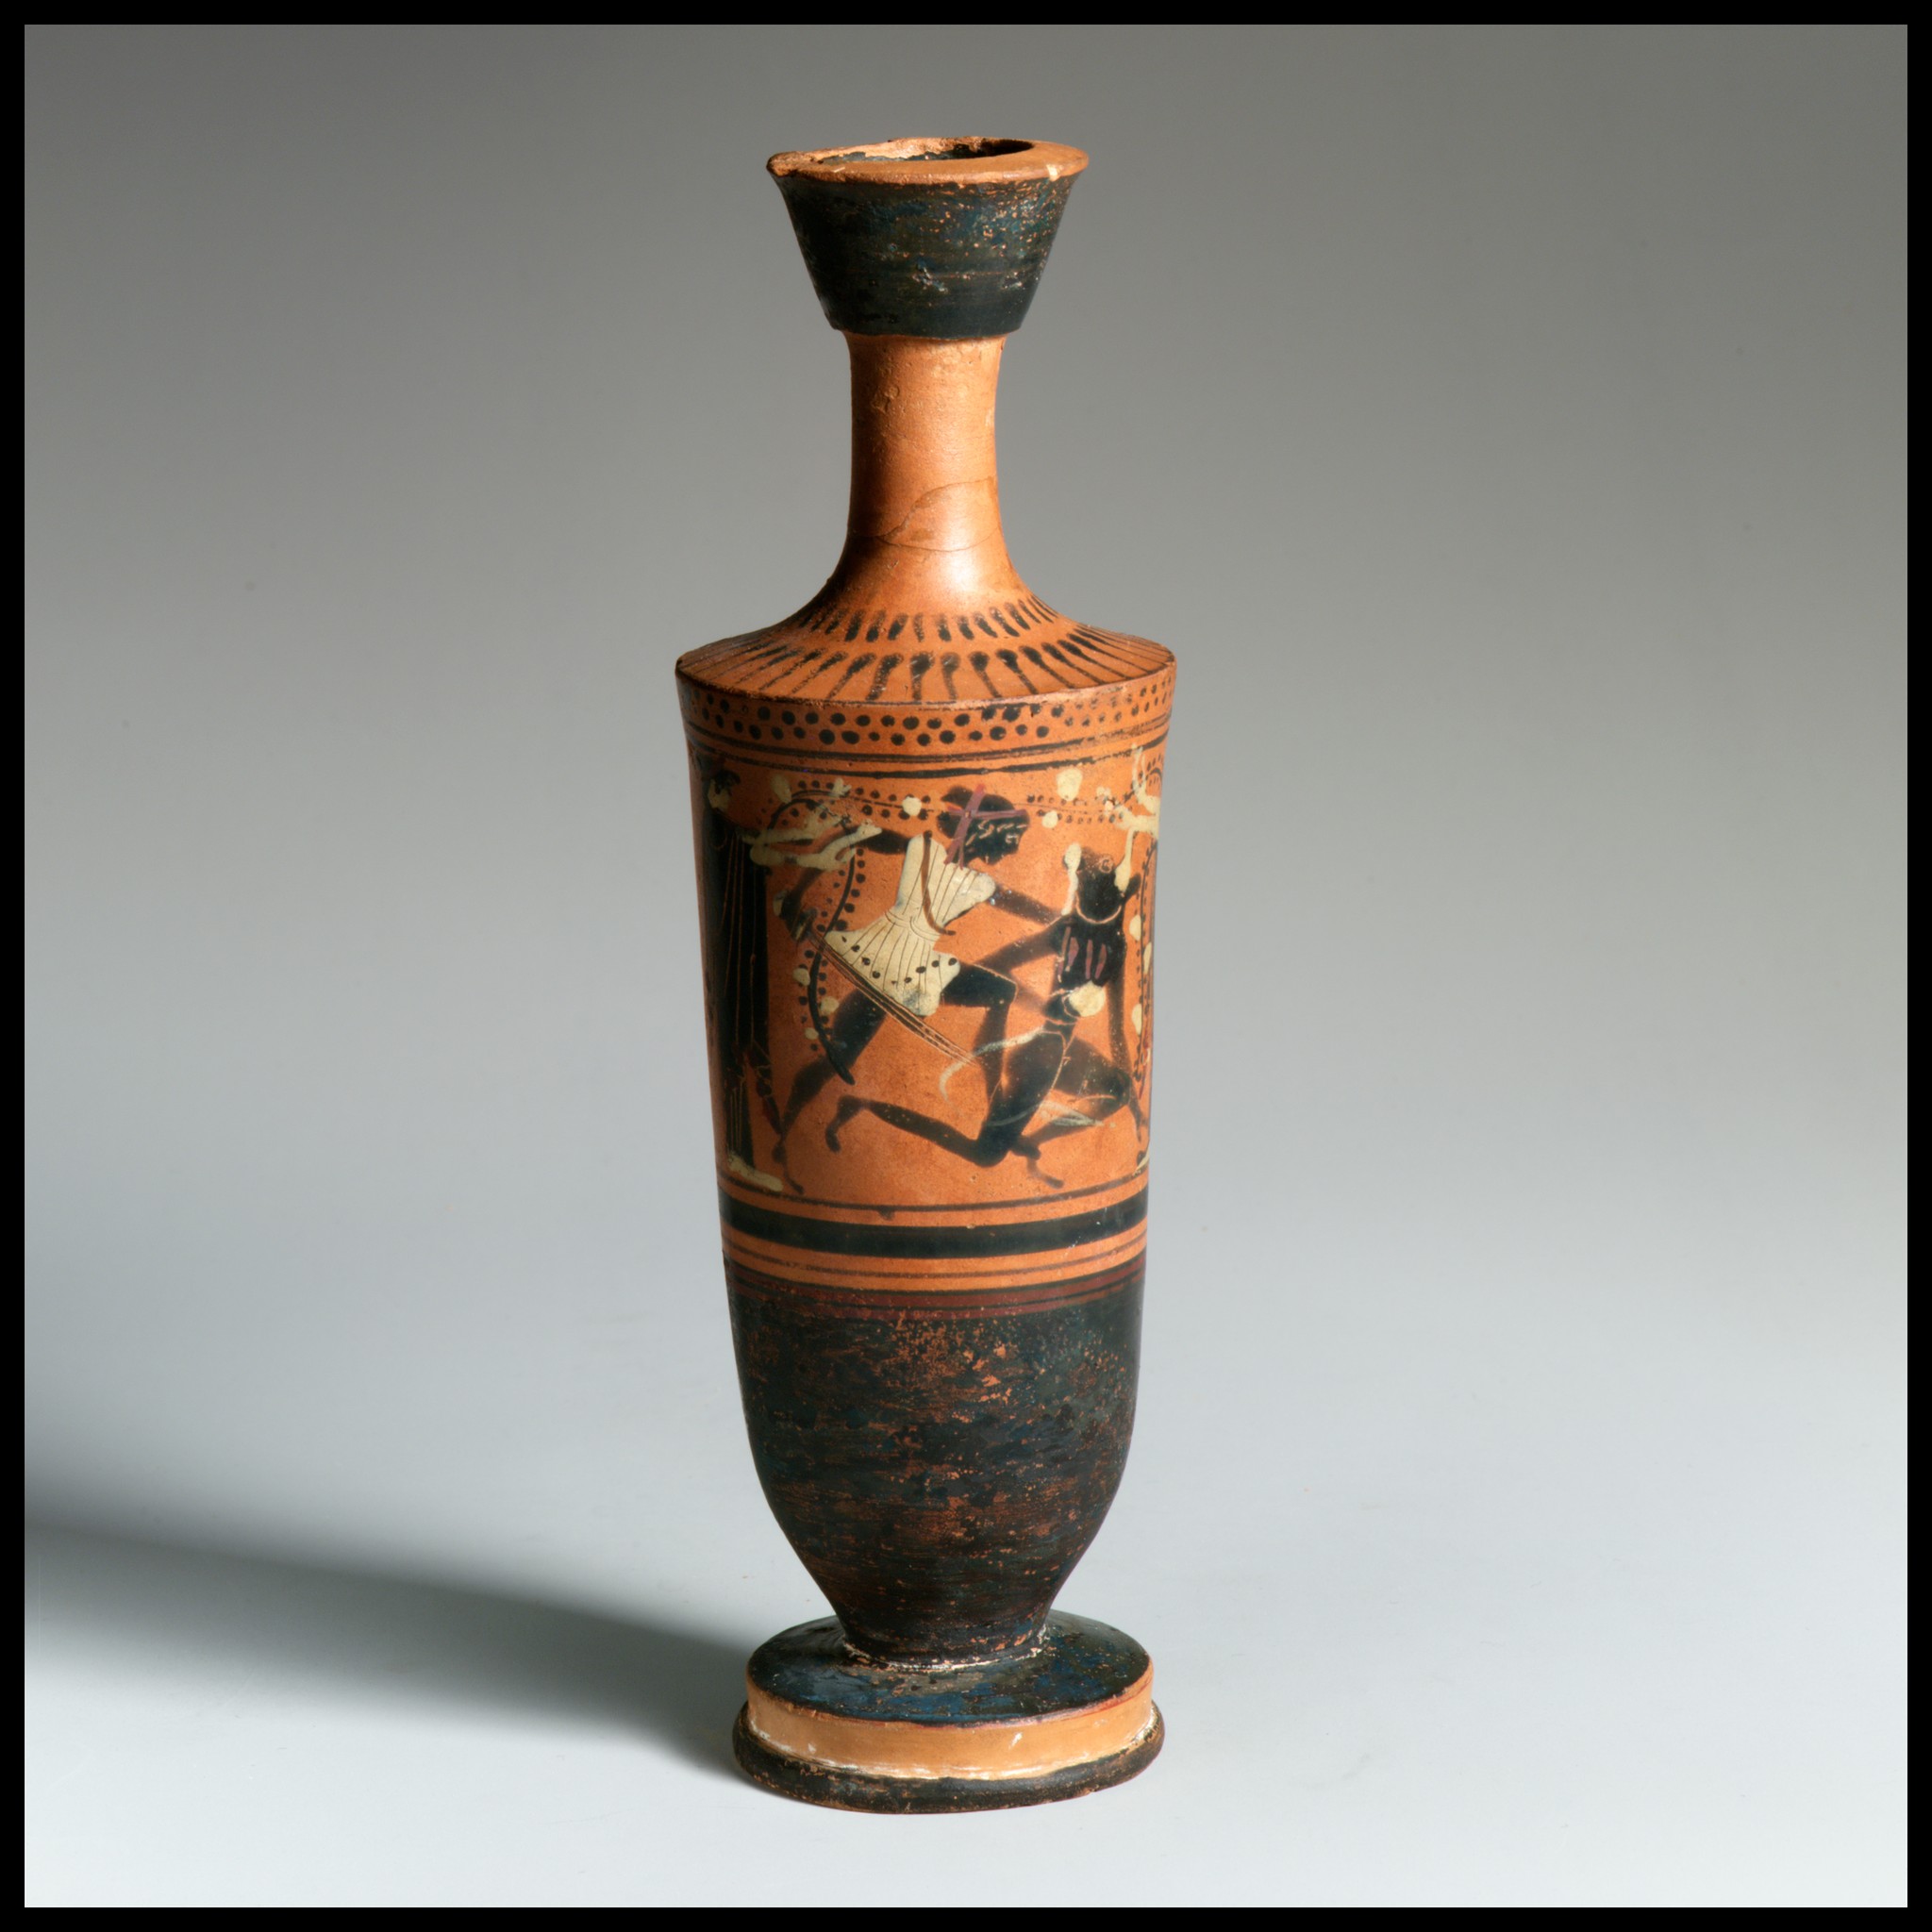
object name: lekythos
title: Terracotta lekythos (oil flask)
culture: greek, attic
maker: diosphos painter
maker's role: artist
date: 500 BCE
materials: terracotta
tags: women,theseus,minotaurs